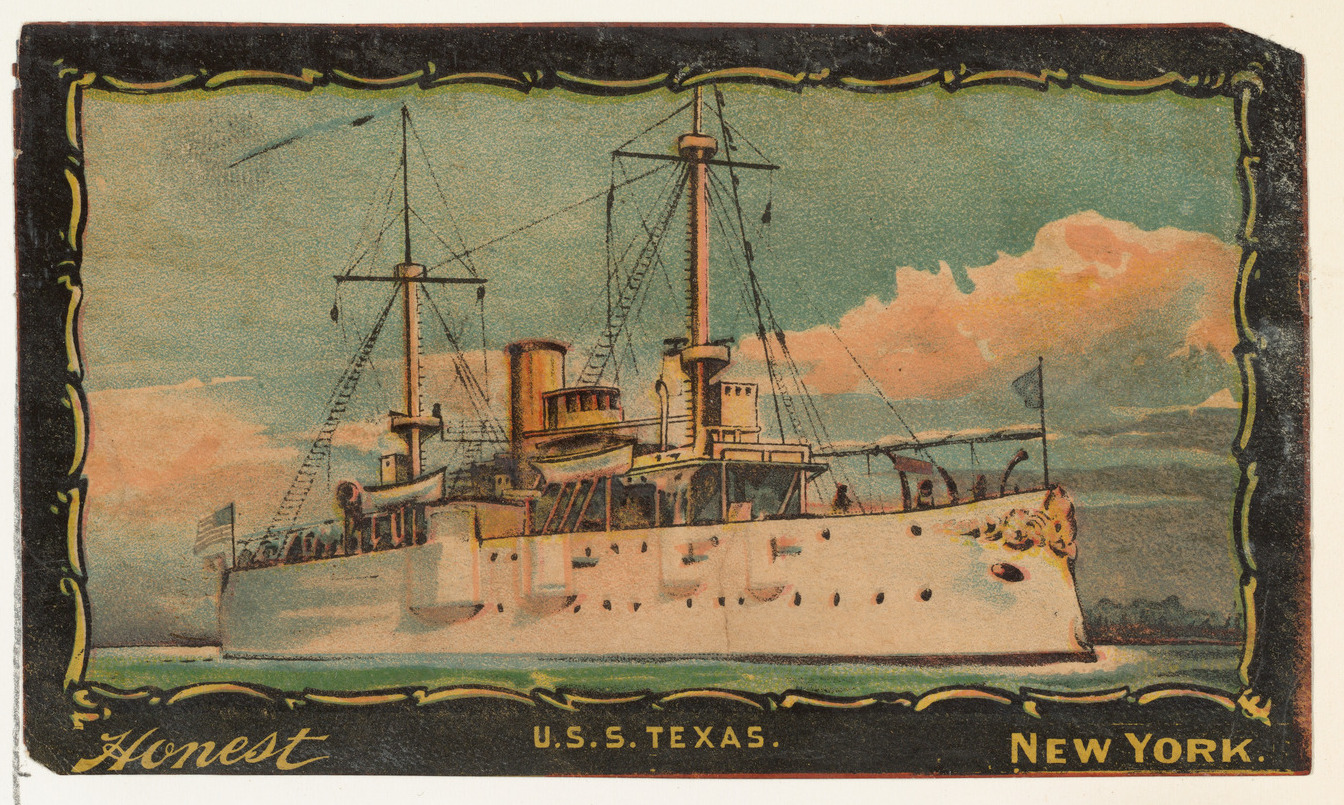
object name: print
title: U.S.S. Texas, from the Transparencies series (N137) issued by W. Duke, Sons & Co. to promote Honest Long Cut Tobacco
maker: w. duke, sons & co.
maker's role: publisher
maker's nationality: american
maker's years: 1870-1920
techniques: color lithograph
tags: ships